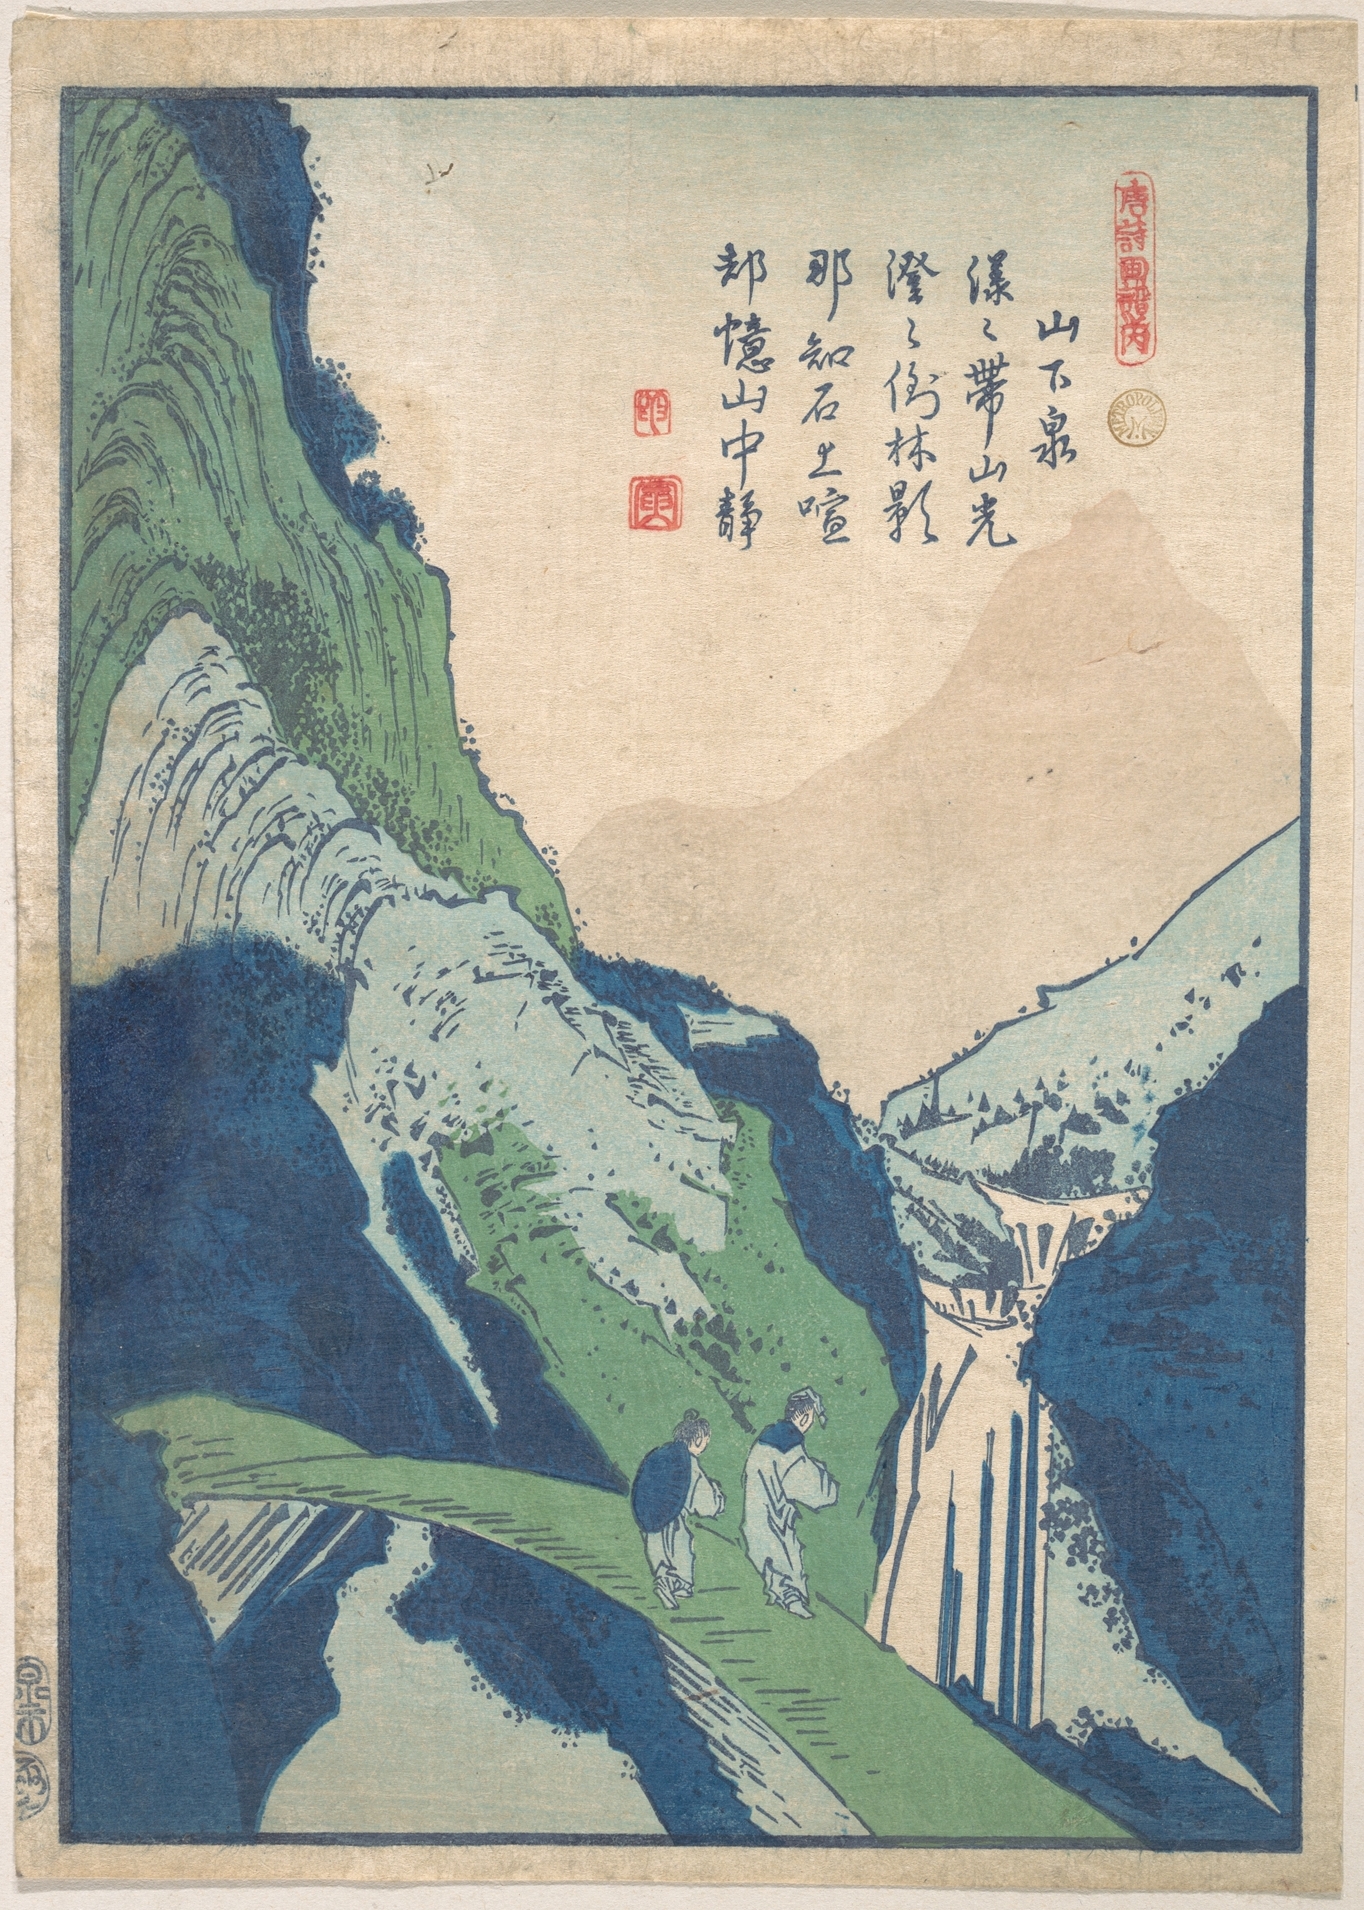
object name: print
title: A Romantic Scene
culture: japanese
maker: totoya hokkei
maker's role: artist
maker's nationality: japanese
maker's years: 1780-1850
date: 1780-1850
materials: ink, paper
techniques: woodblock print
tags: human figures,waterfalls,mountains